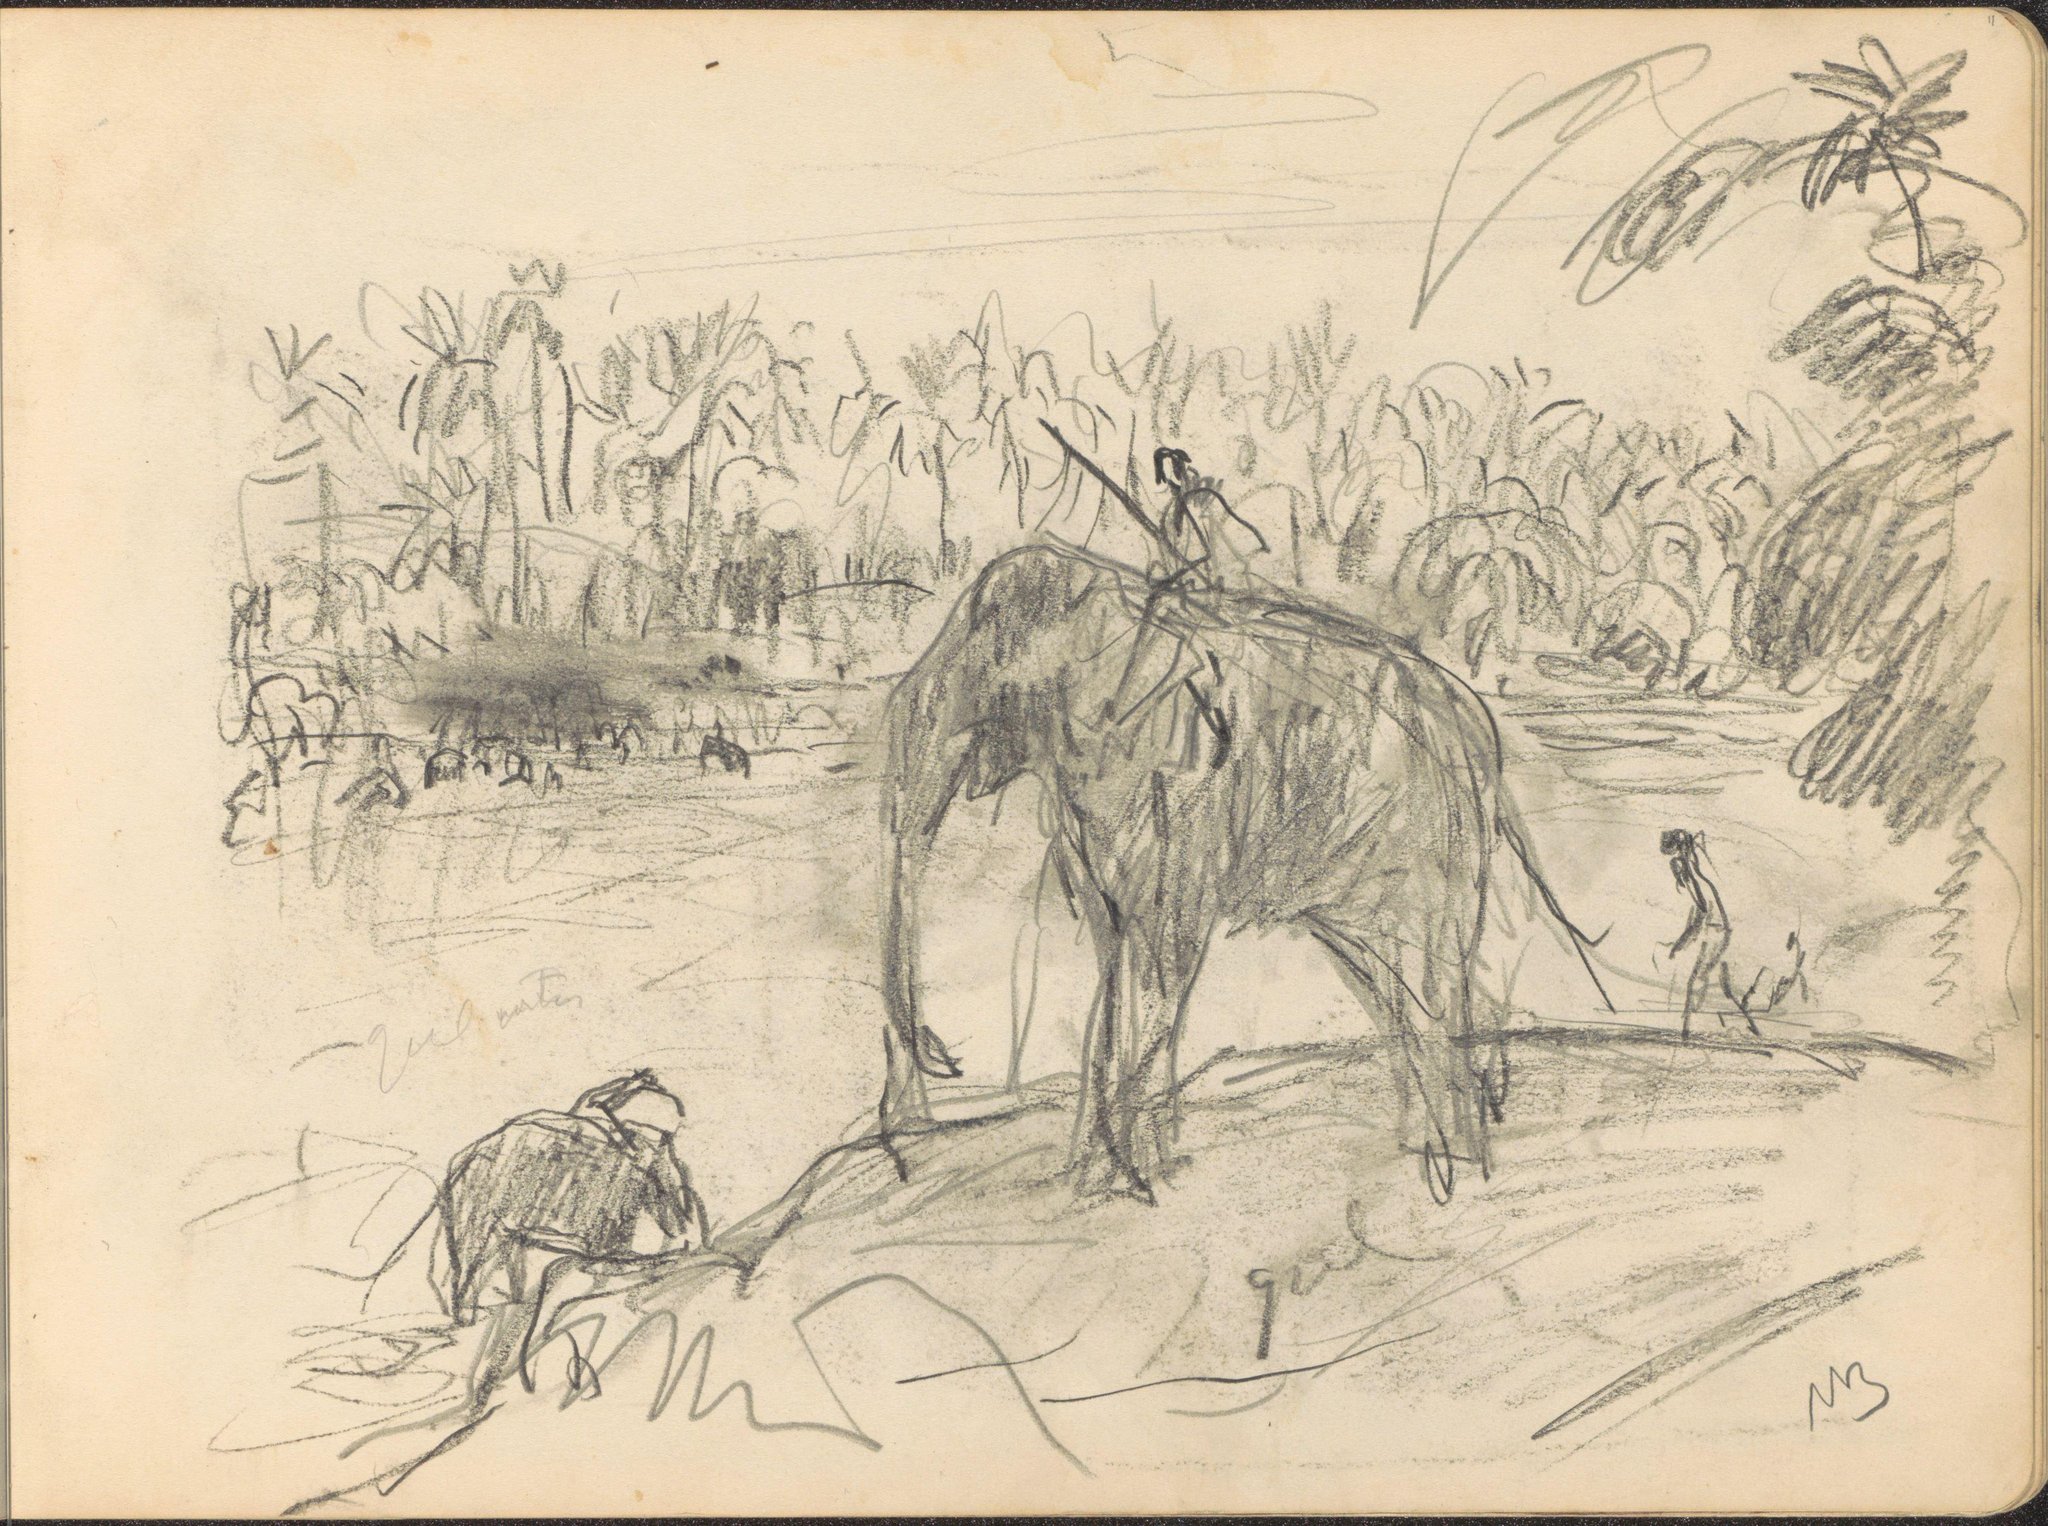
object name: sketchbook leaf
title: Olifant bij een rivier in het oerwoud van Ceylon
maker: marius bauer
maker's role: draughtsman, print maker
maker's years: 1867-1932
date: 1924-1925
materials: chalk, paper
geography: sri lanka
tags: sitting figure, river, jungle, trunked animals: elephant, sri lanka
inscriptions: monogram: ‘MB’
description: Op de olifant zit een figuur met een stok. Pagina 11 uit een schetsboek met 20 bladen.